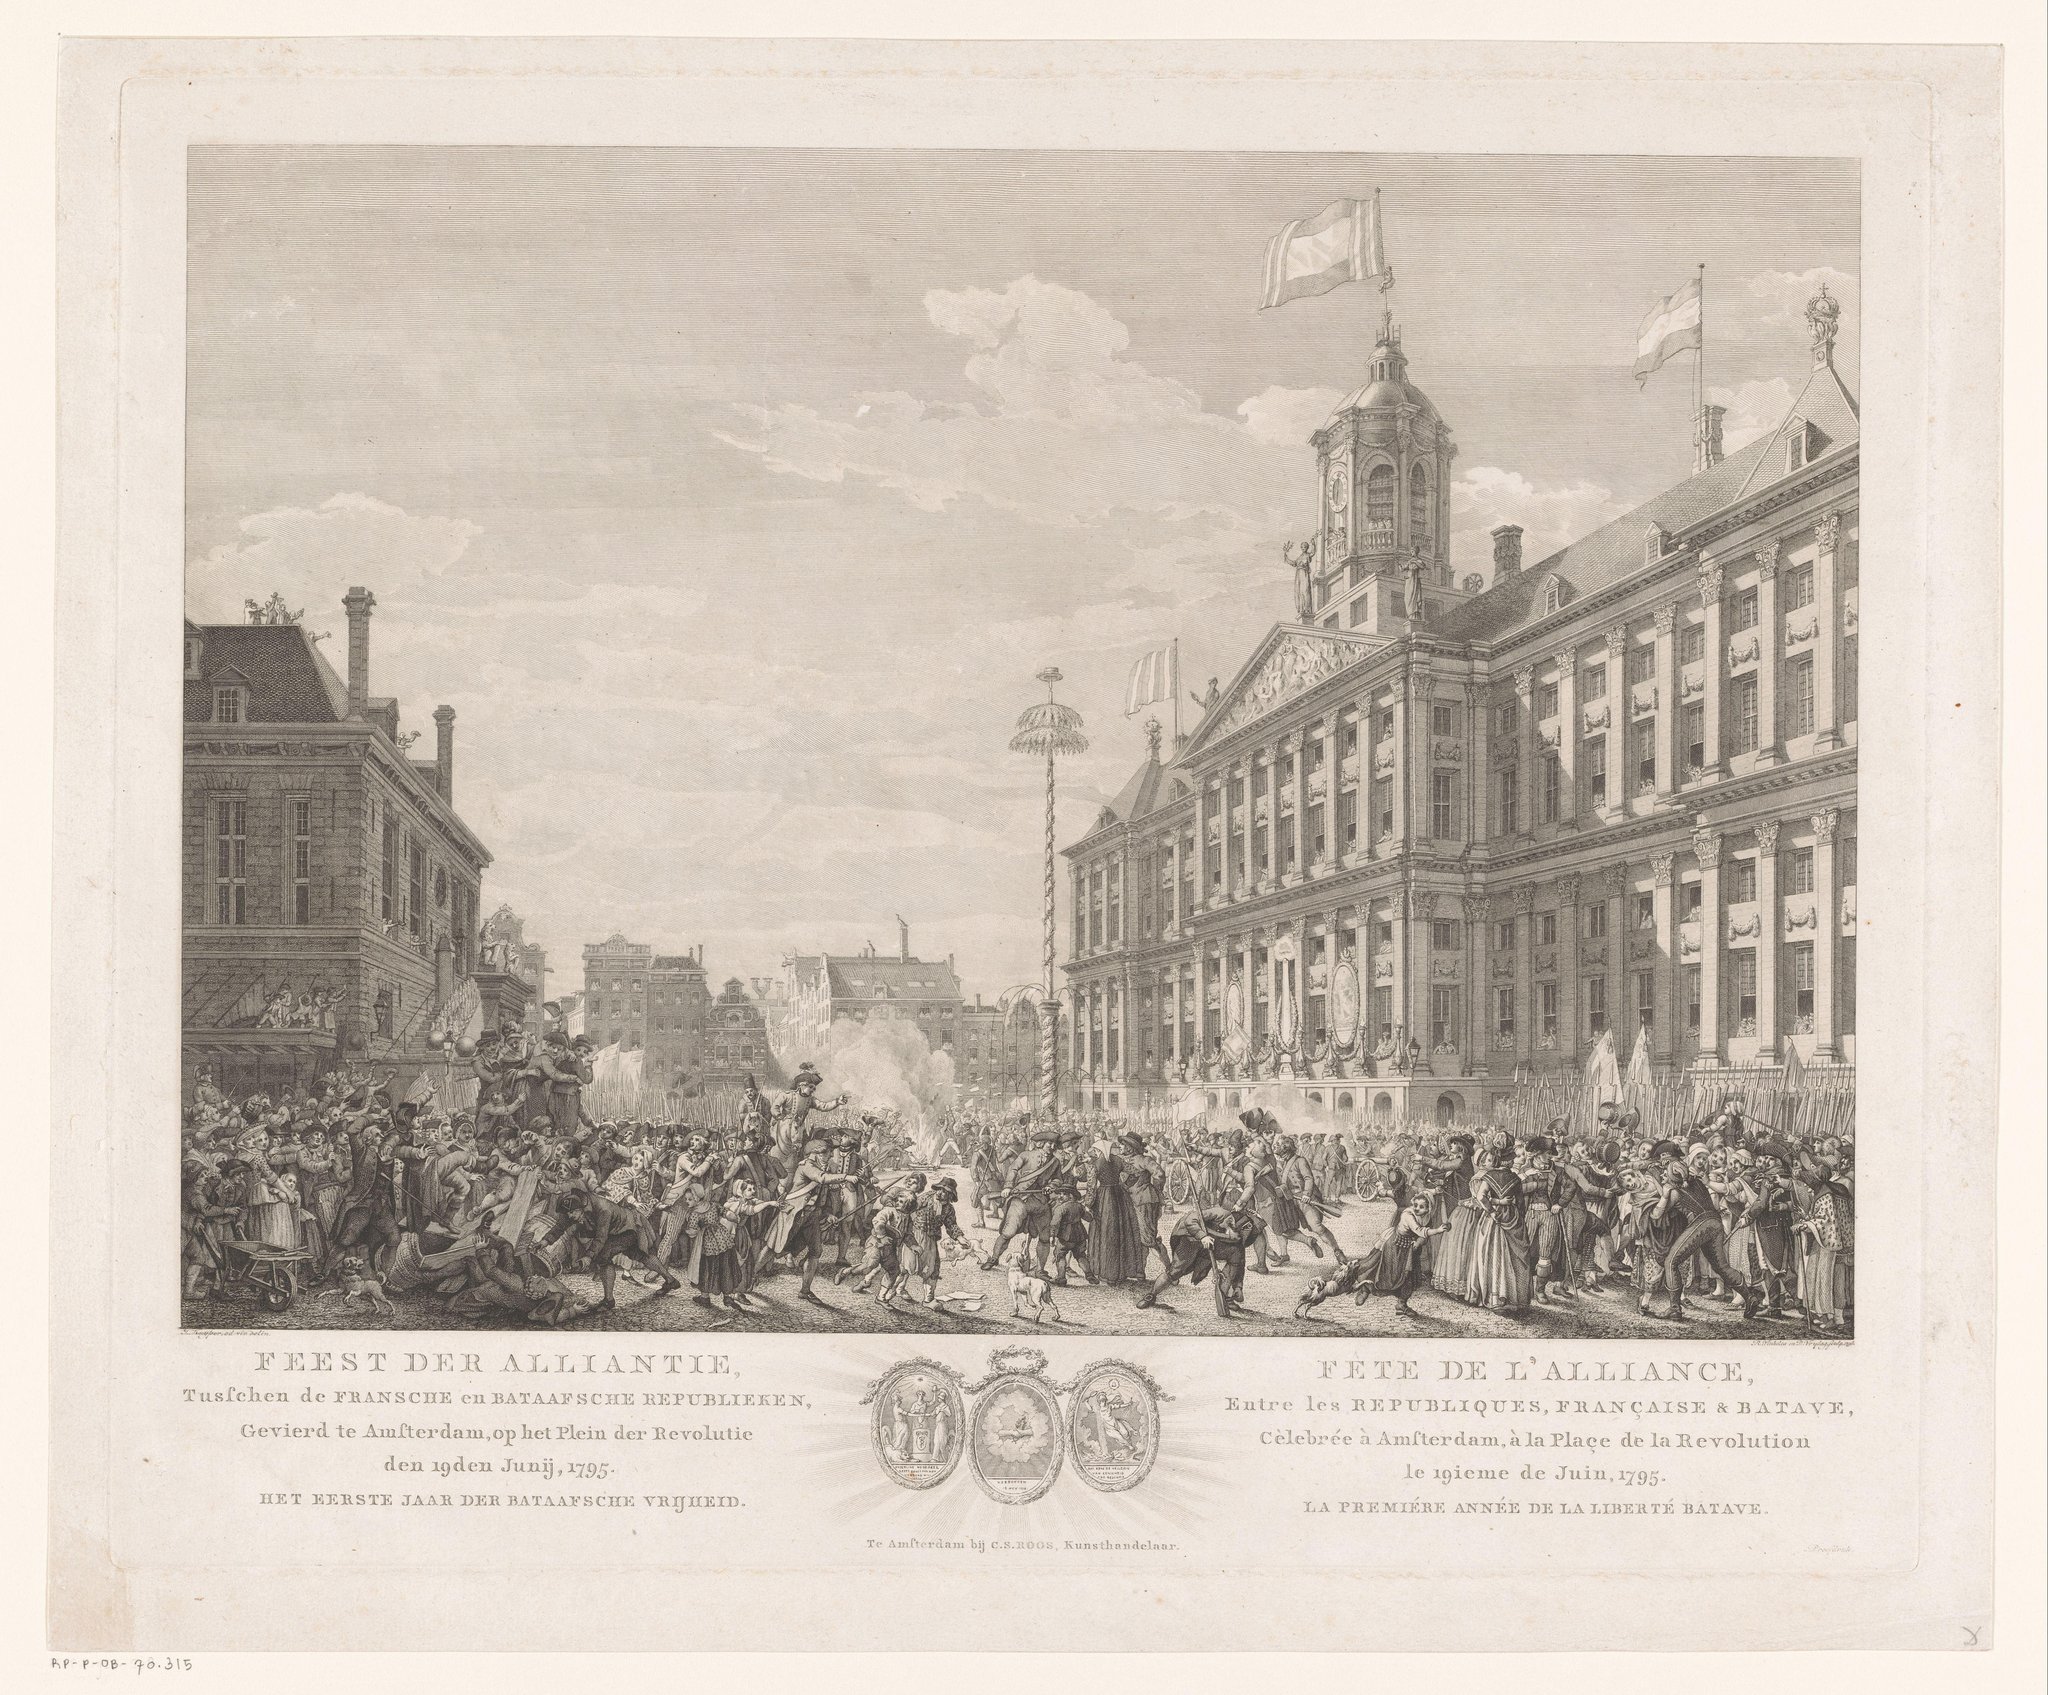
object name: print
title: "Feest der Alliantie (...) te Amsterdam, op het Plein der Revolutie den 19den Junij, 1795."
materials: paper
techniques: etching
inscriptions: date